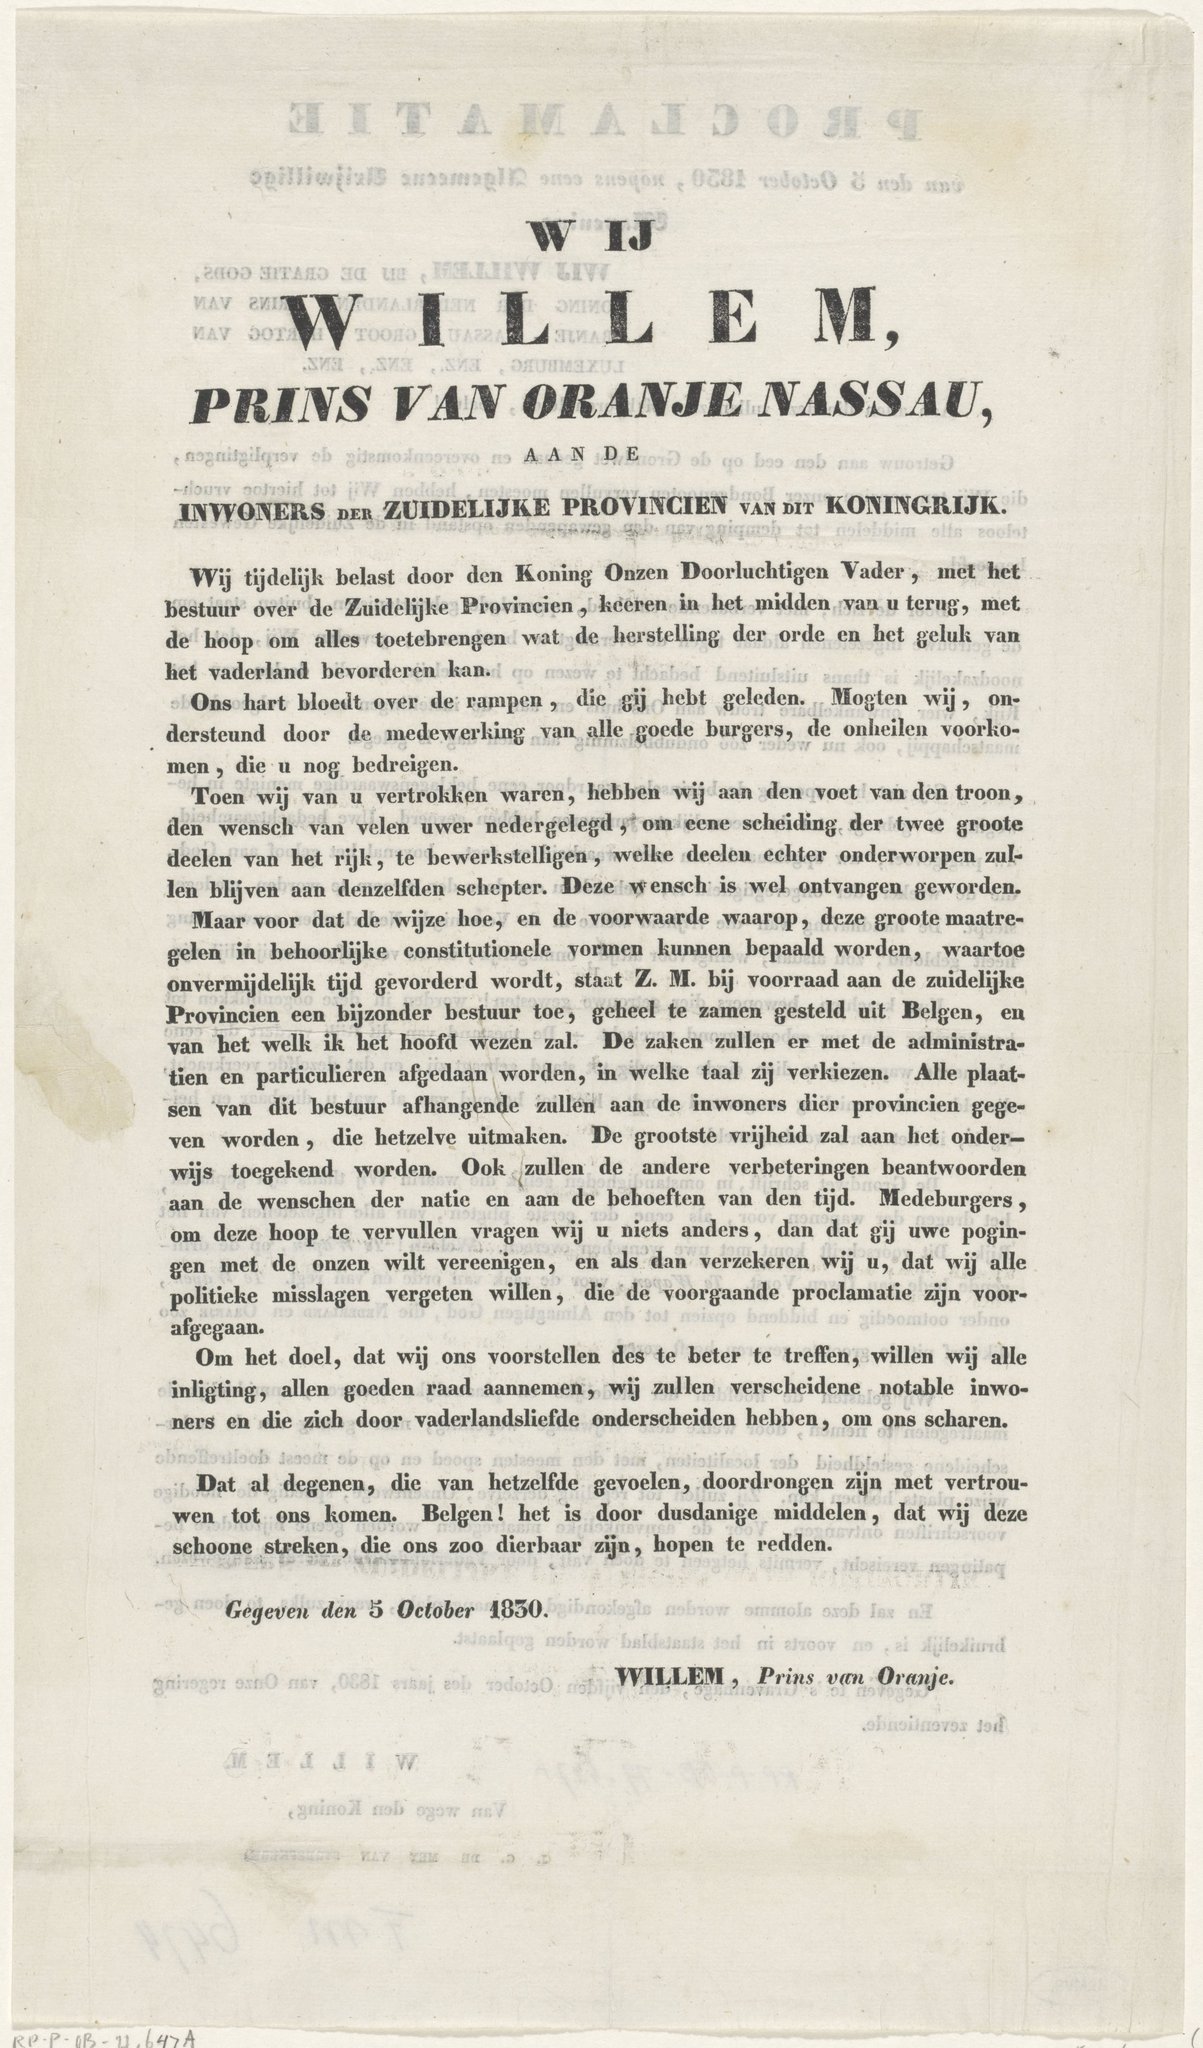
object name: proclamation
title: Proclamatie van de koning met oproep tot vrijwillige wapening, 1830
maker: Anonymous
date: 1830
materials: paper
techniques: letterpress printing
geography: the hague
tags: william i of the netherlands, william ii of the netherlands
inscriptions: collector's mark: Lugt 2228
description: Proclamatie in naam van koning Willem I, waarin de oproep tot vrijwillige wapening van de burgers, 5 oktober 1830. Naar aanleiding van de gewapende opstand in de zuidelijke gewesten. Blad op beide zijden bedrukt. Op de achterzijde een oproep van de kroonprins aan de Belgen: 'Wij Willem, prins van Oranje Nassau, aan de Inwoners der Zuidelijke Provincien van dit Koningrijk'.